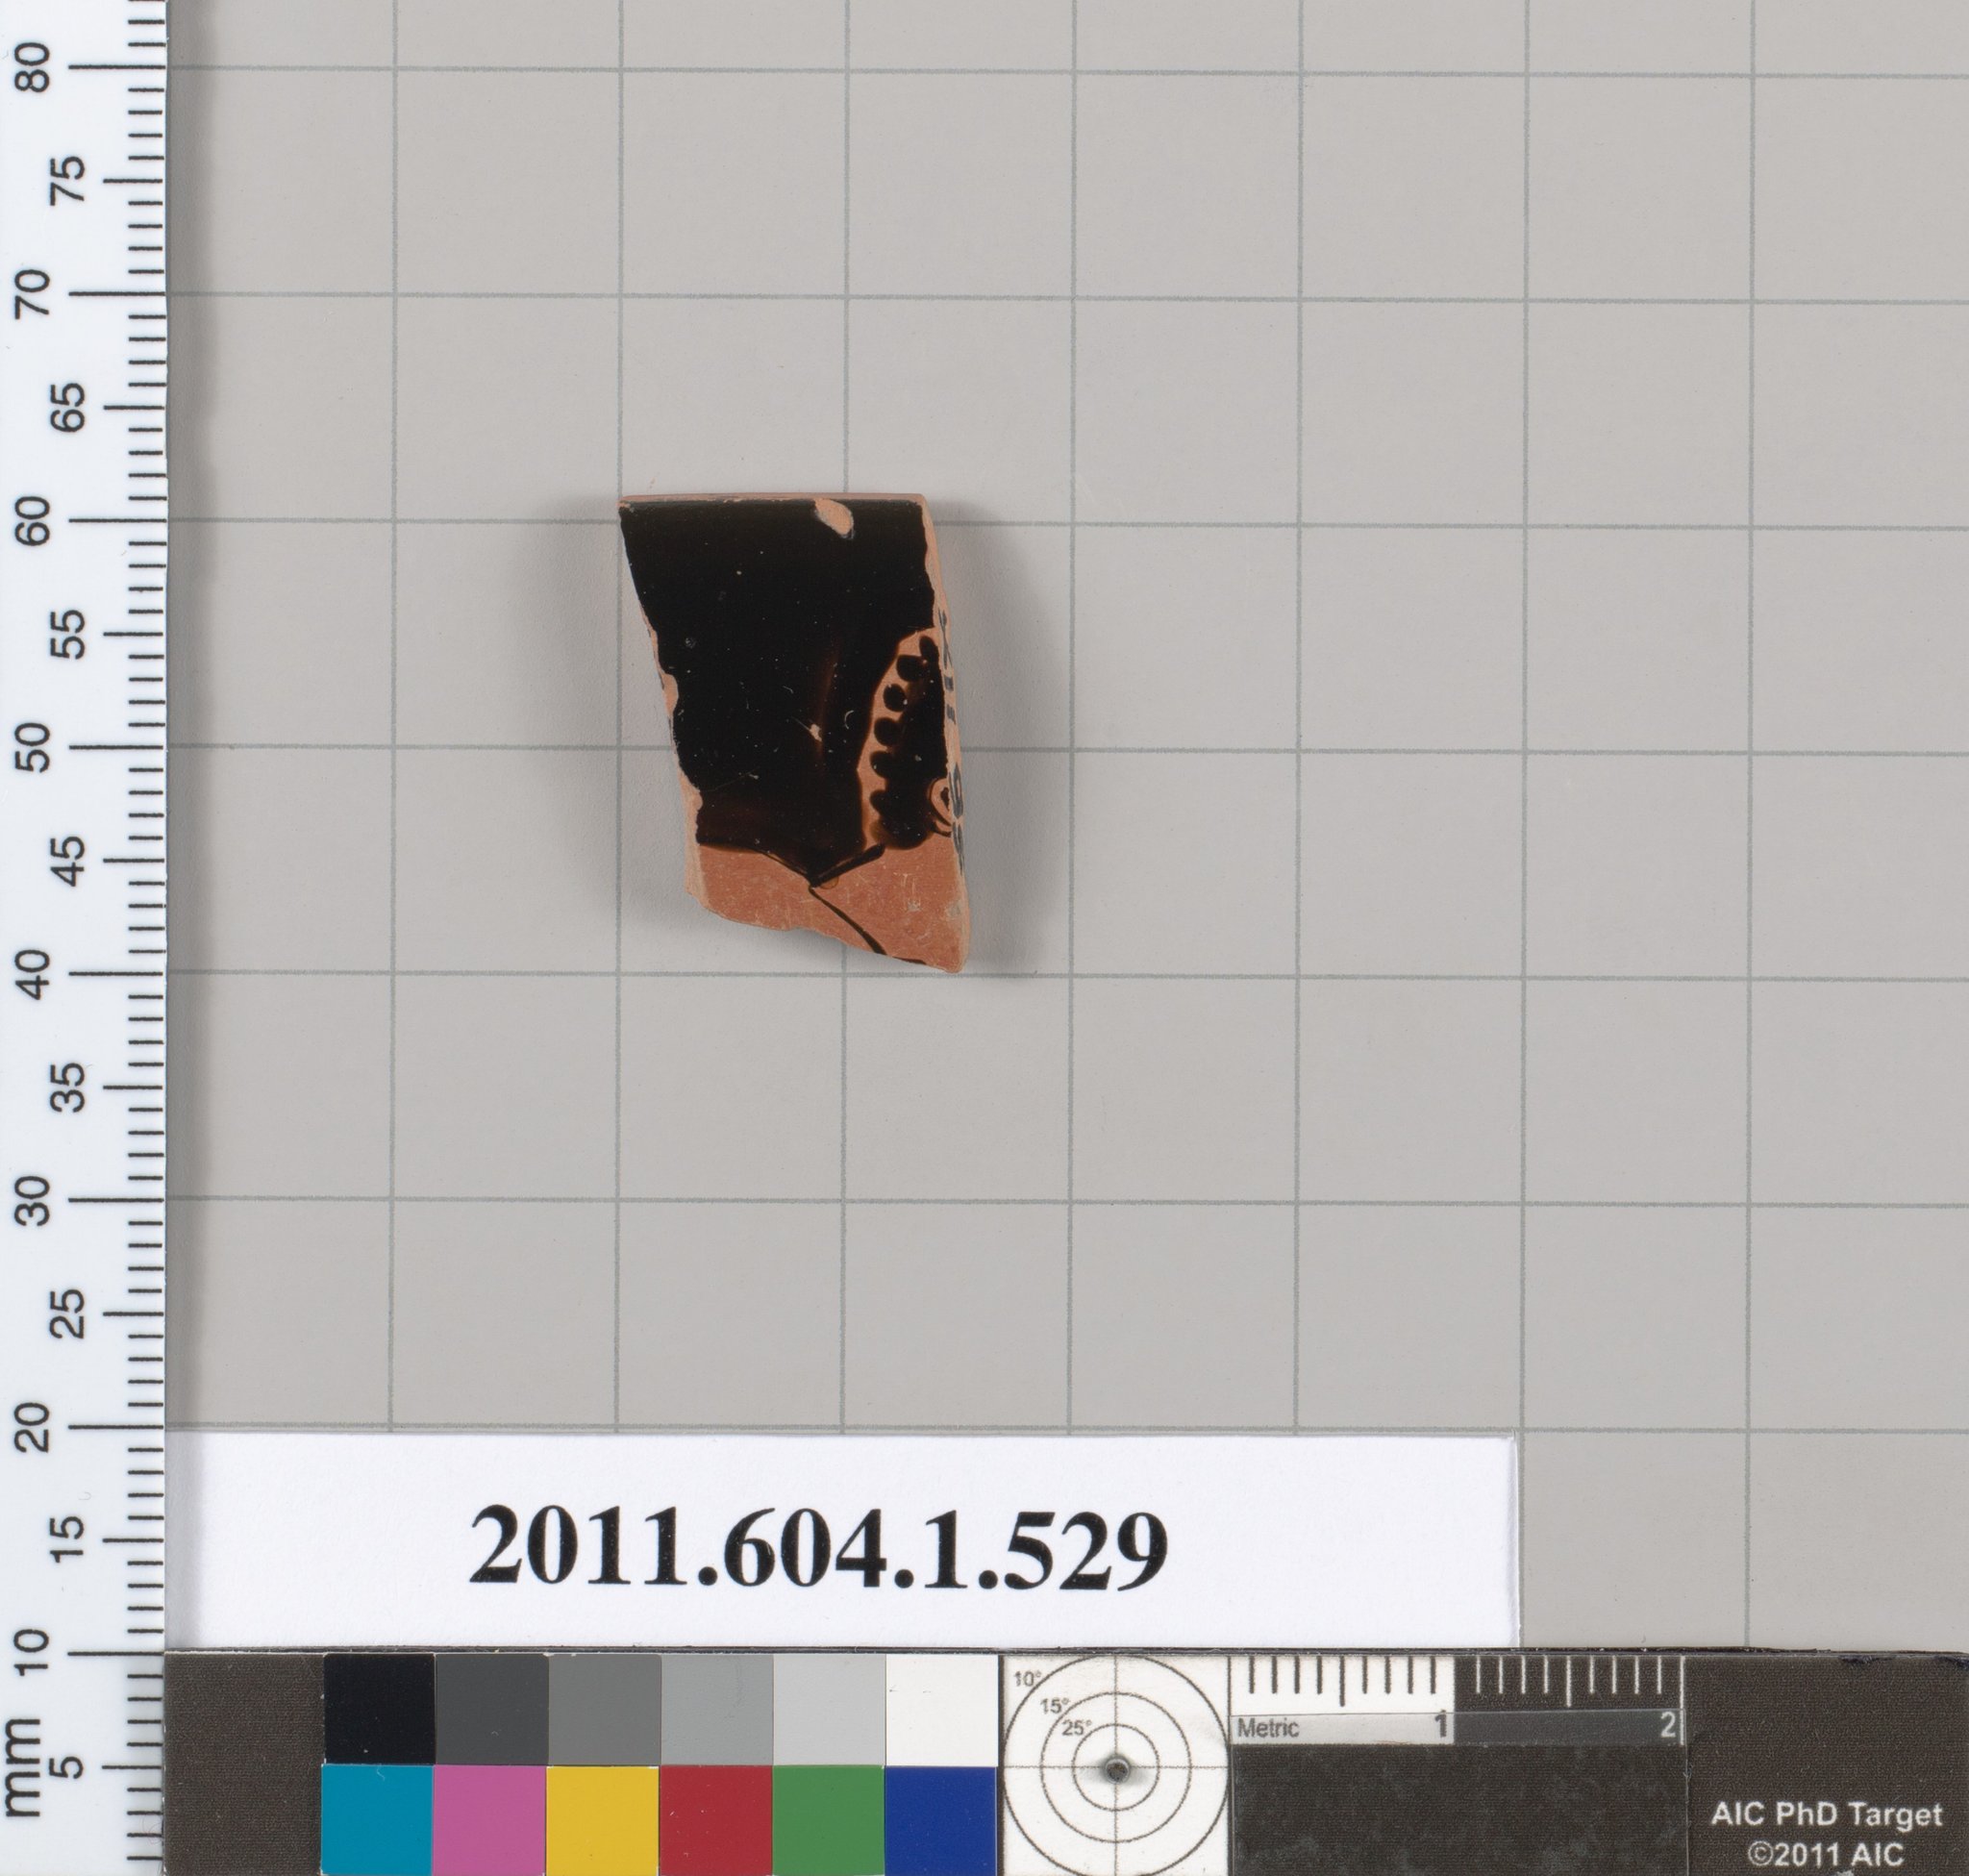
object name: kylix fragment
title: Terracotta rim fragment of a kylix (drinking cup)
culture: greek, attic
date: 480-470 BCE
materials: terracotta